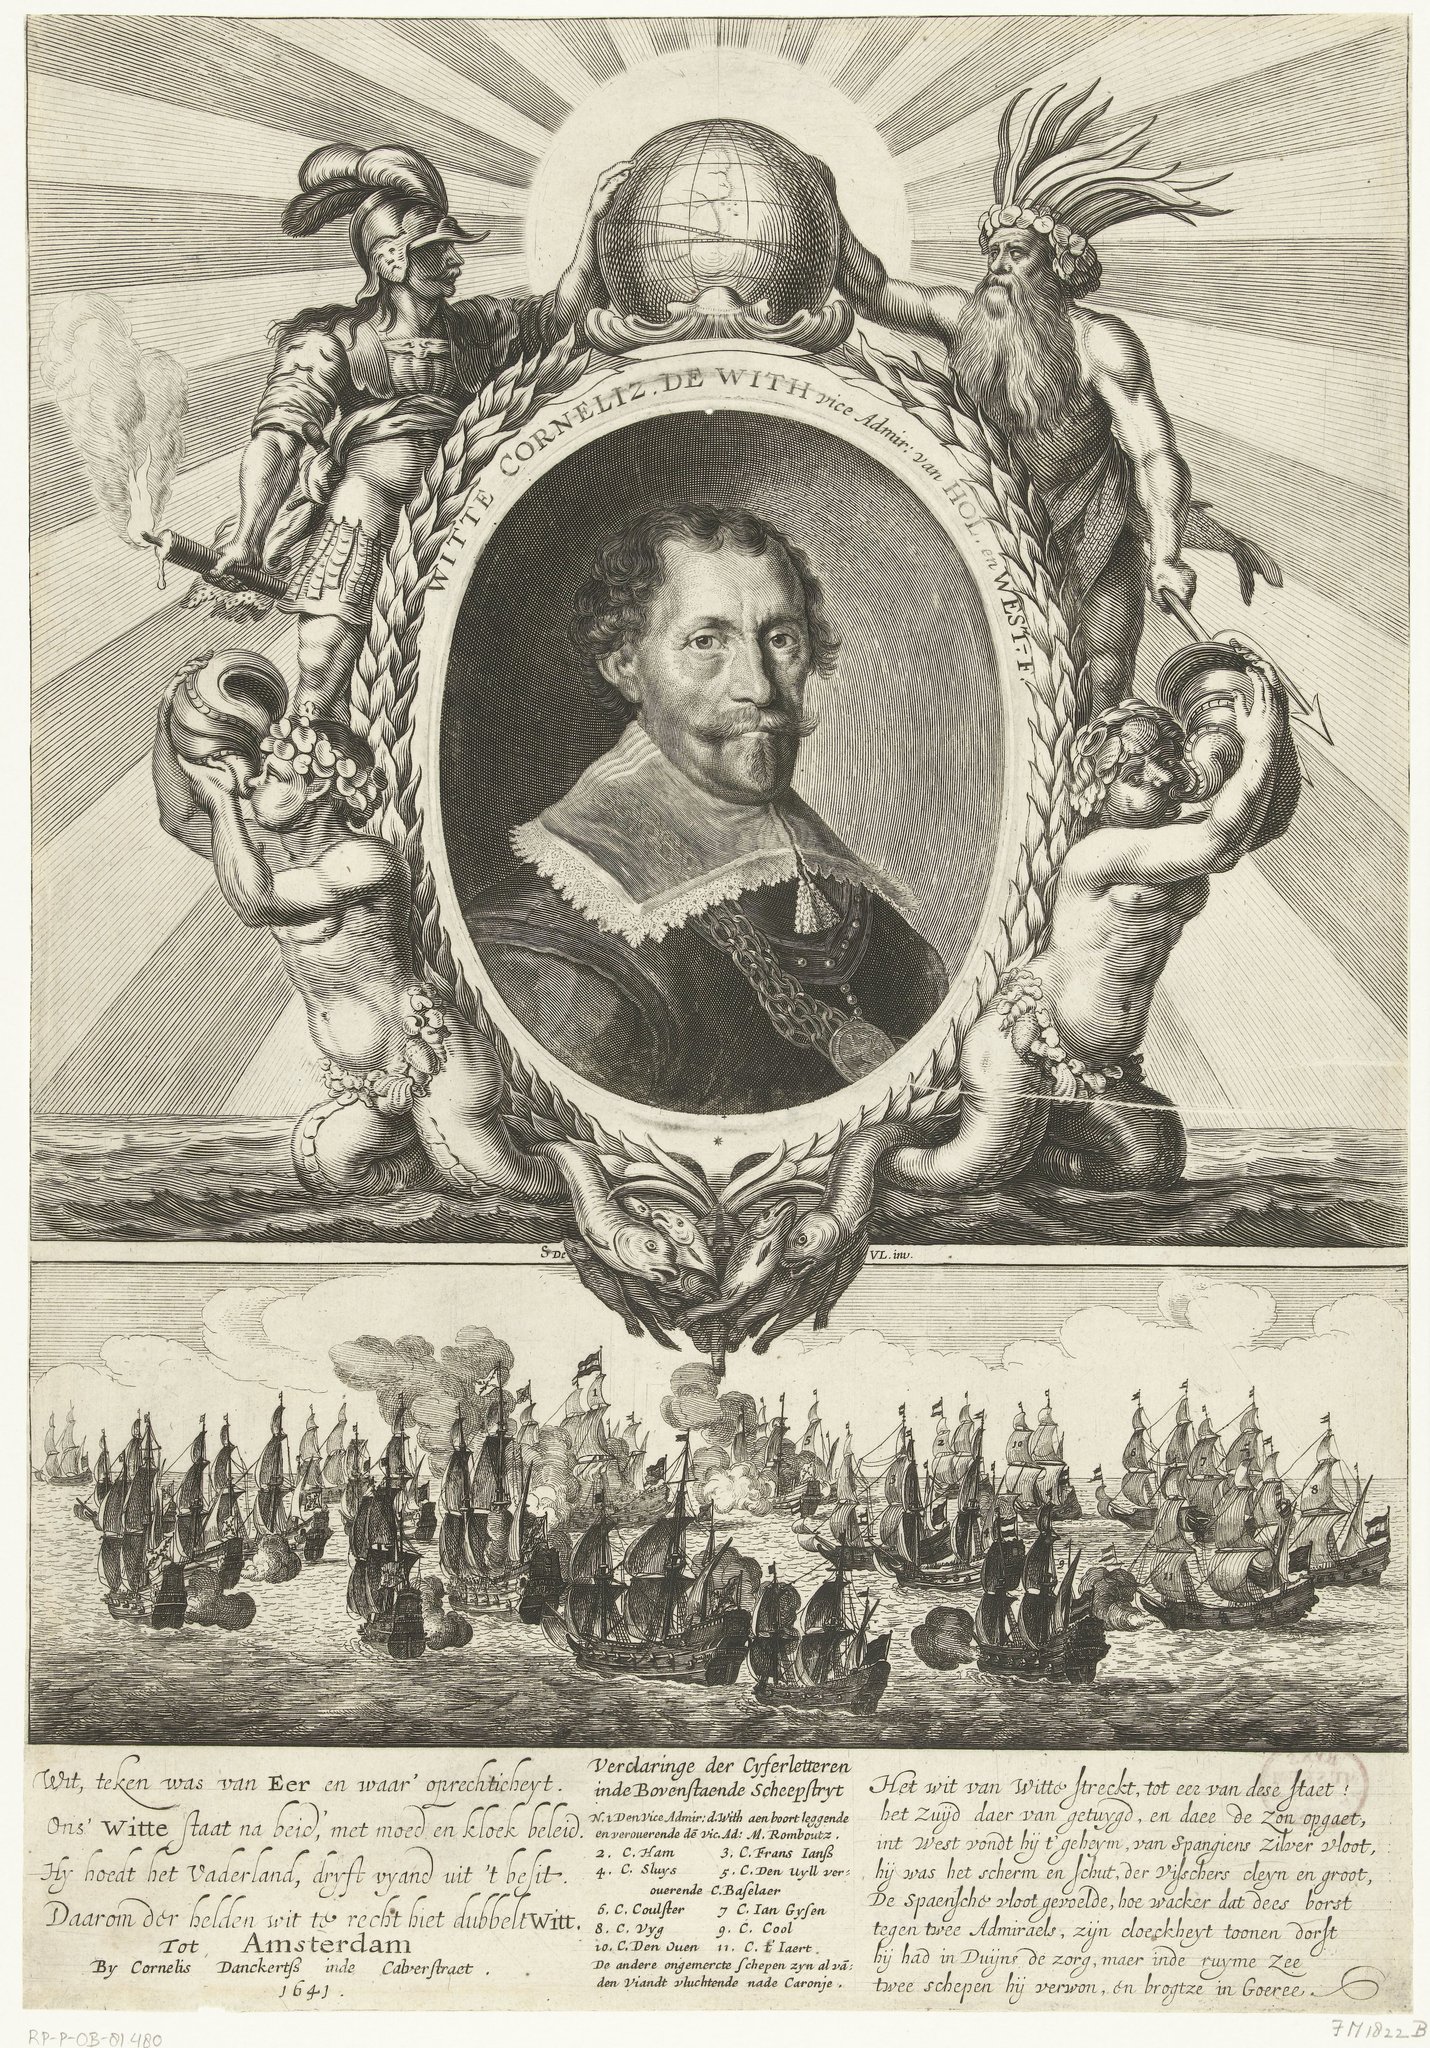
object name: propagandaprent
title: Allegorie op de overwinning van Witte de With op de Duinkerker vice-admiraal Rombouts, 1640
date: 1641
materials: paper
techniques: engraving, etching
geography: northern netherlands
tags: battle (+ naval force)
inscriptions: collector's mark: Lugt 12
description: Allegorie op de overwinning van Witte de With op de Duinkerker vice-admiraal Rombouts, juli 1640. Centraal een plaat van een ovaal portret van Witte de With gedrukt binnen een omlijsting versierd met Mars, Pluto en tritonen. Onderaan een voorstelling van de zeeslag met twee verzen van elk 4 en 8 regels in het Nederlands. In het midden de verklaring van de cijfers 1-11.